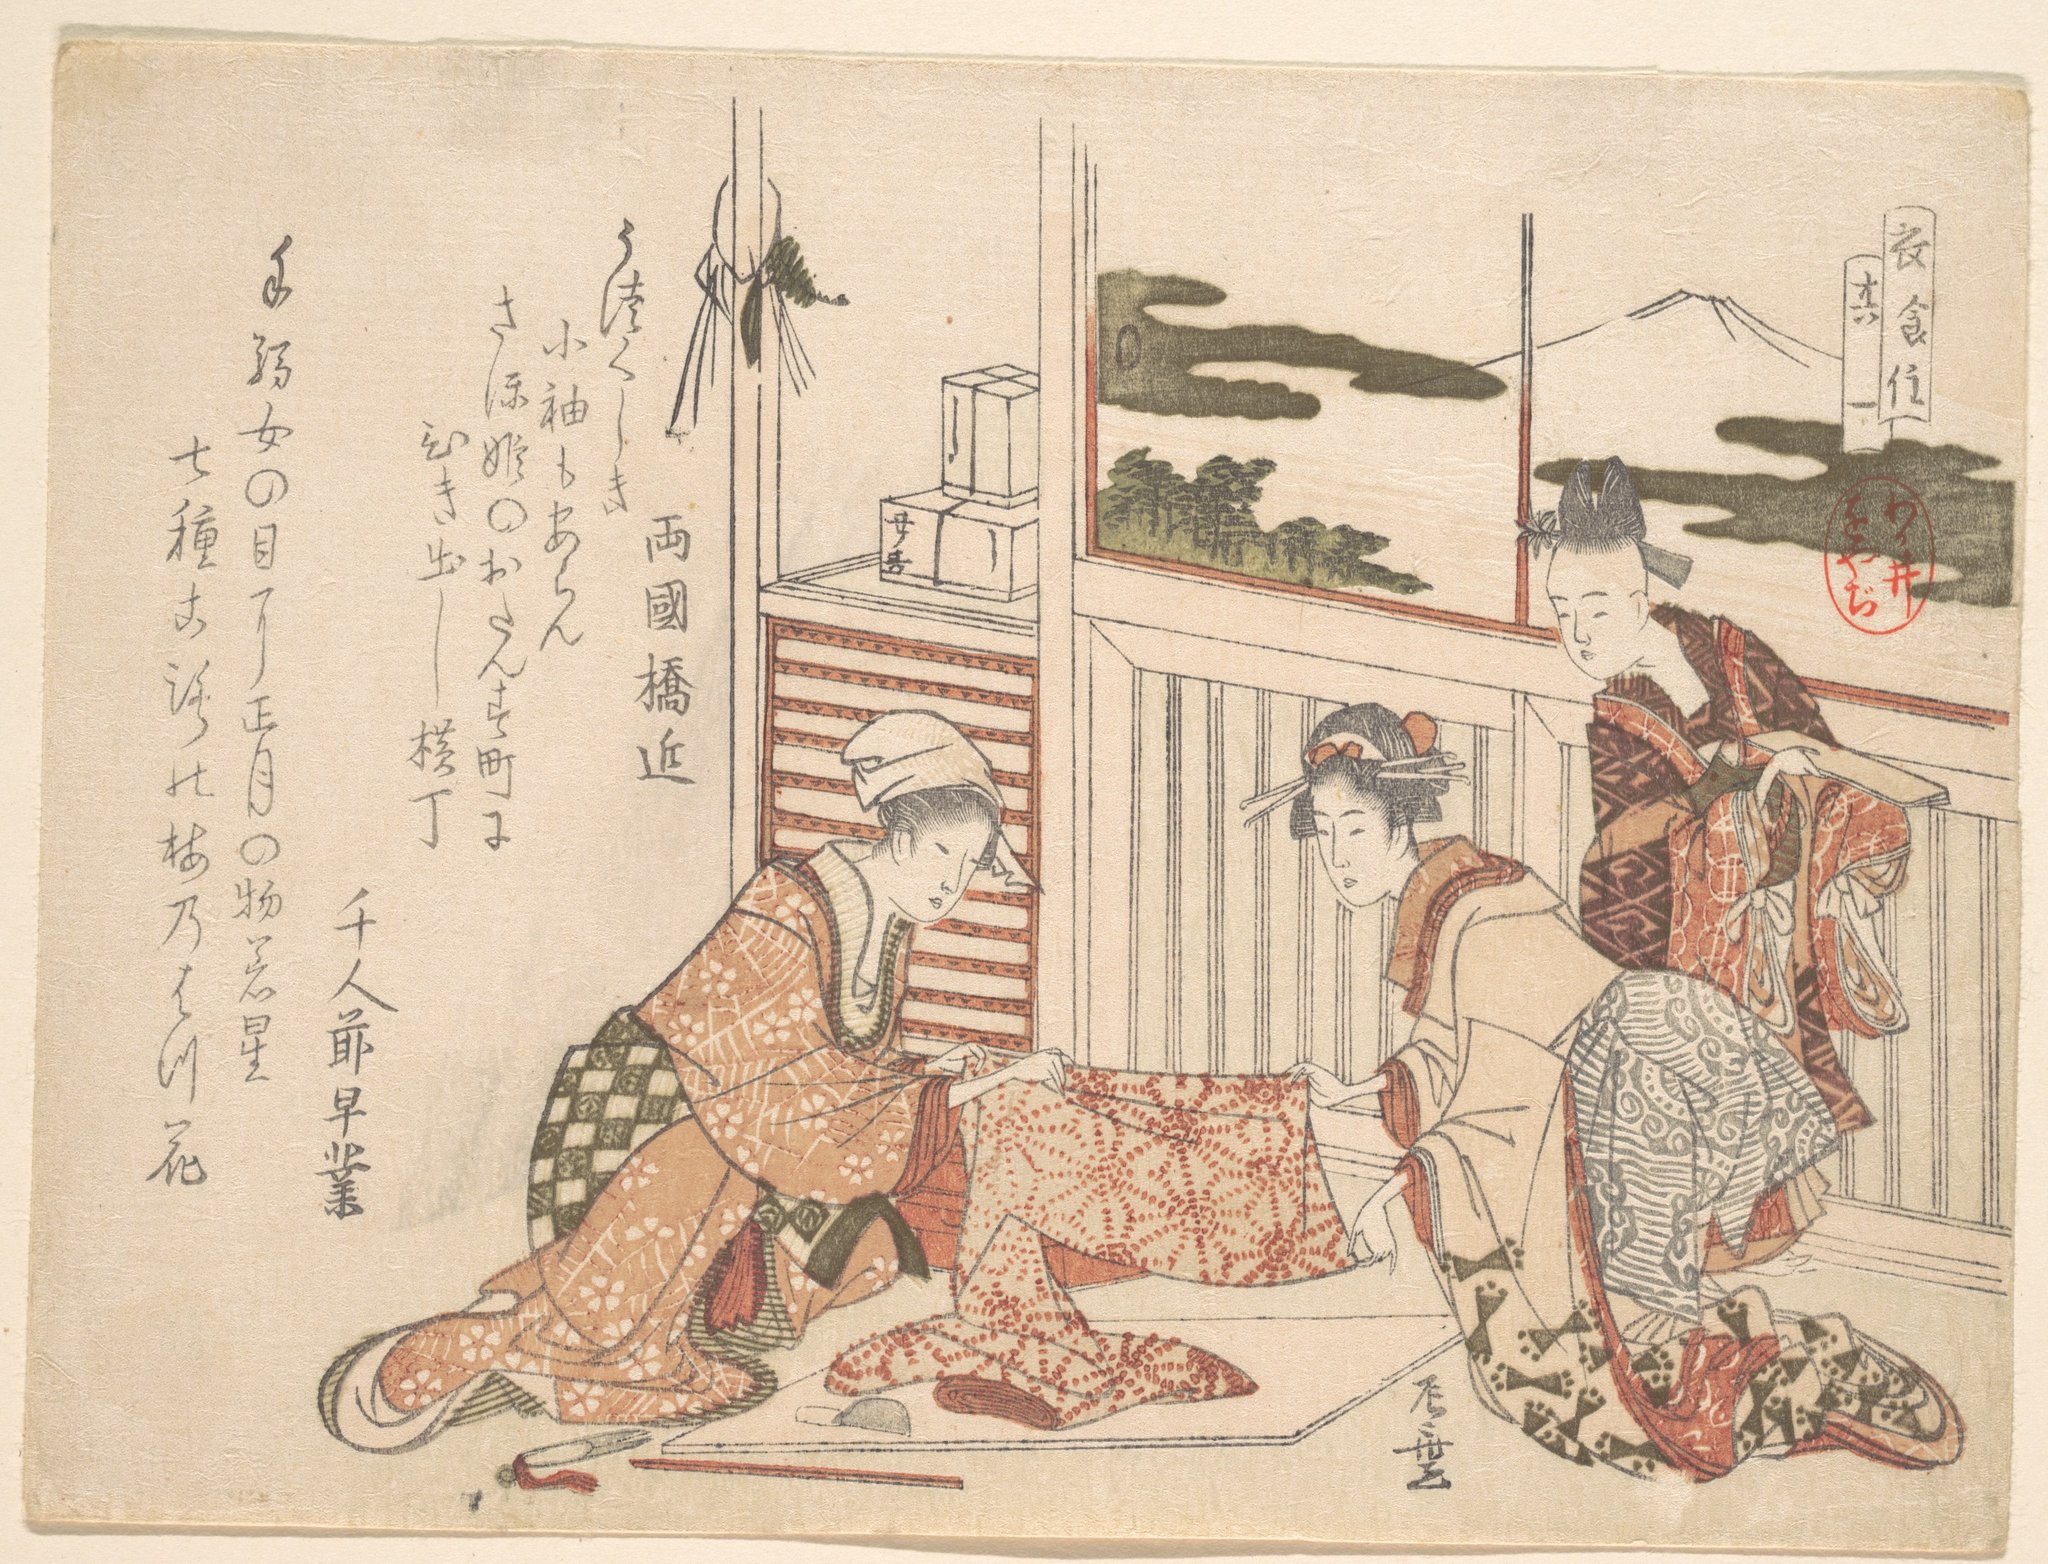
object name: print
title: Attire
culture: japanese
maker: katsushika hokusai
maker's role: artist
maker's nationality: japanese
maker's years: 1760-1849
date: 1760-1849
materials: ink, paper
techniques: surimono, woodblock print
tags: women